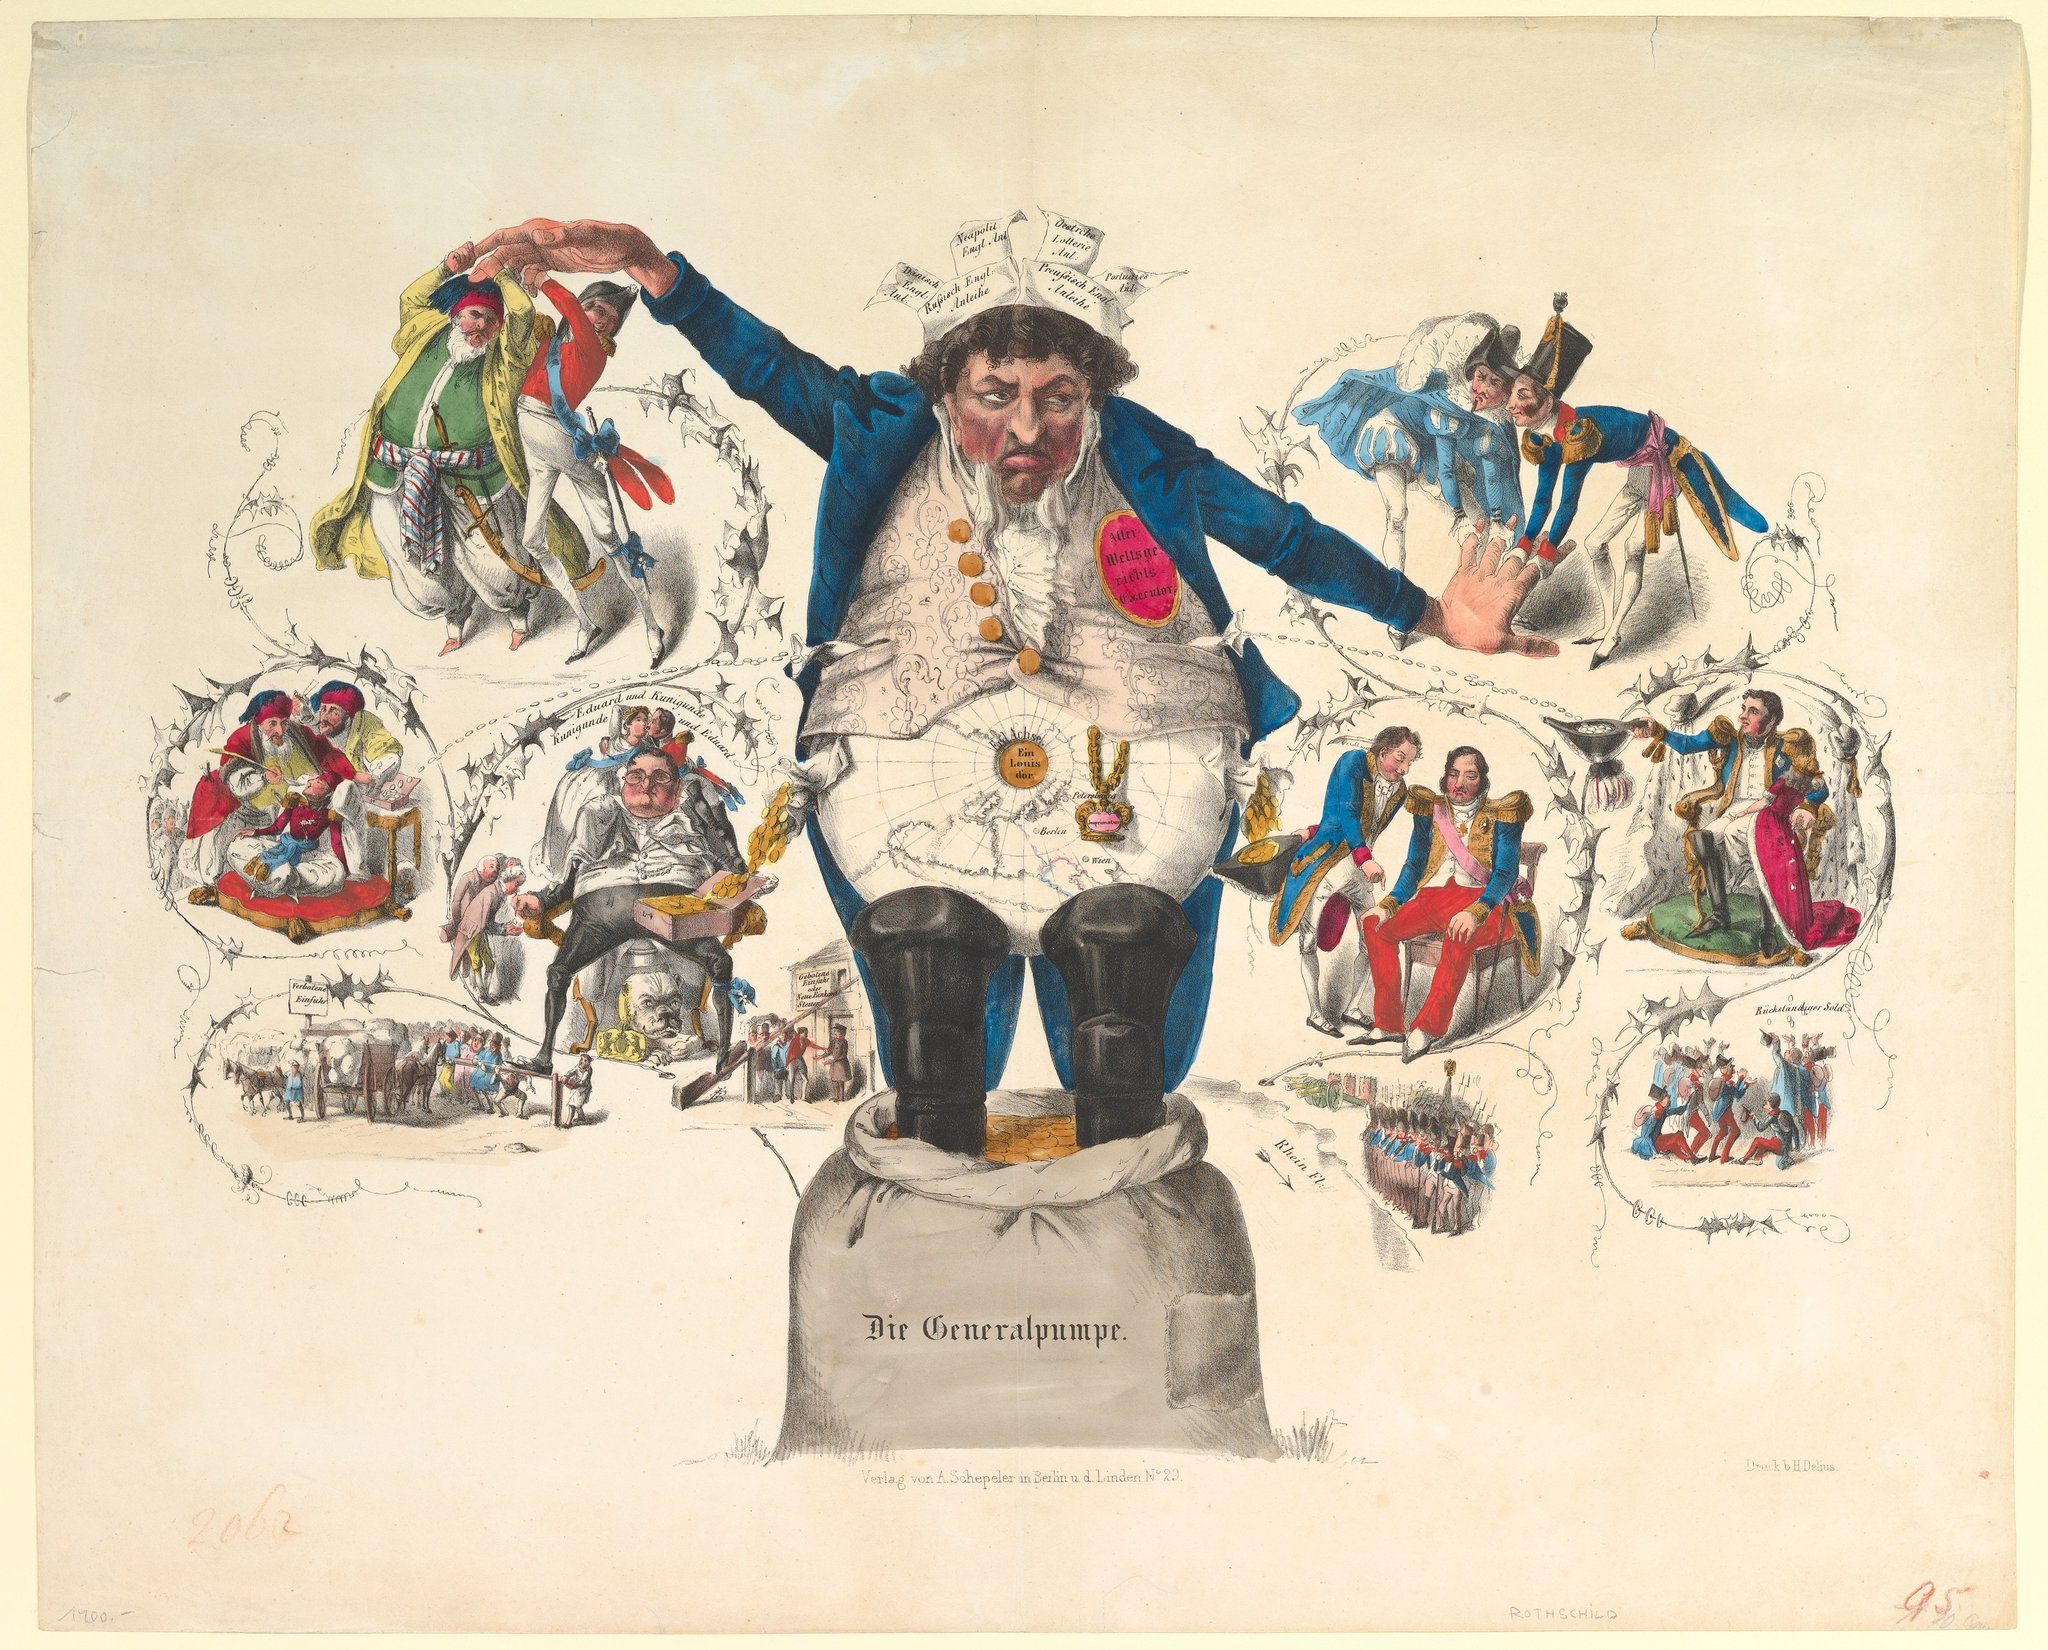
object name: print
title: Die Generalpumpe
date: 1801-1900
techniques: lithograph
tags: satire,men